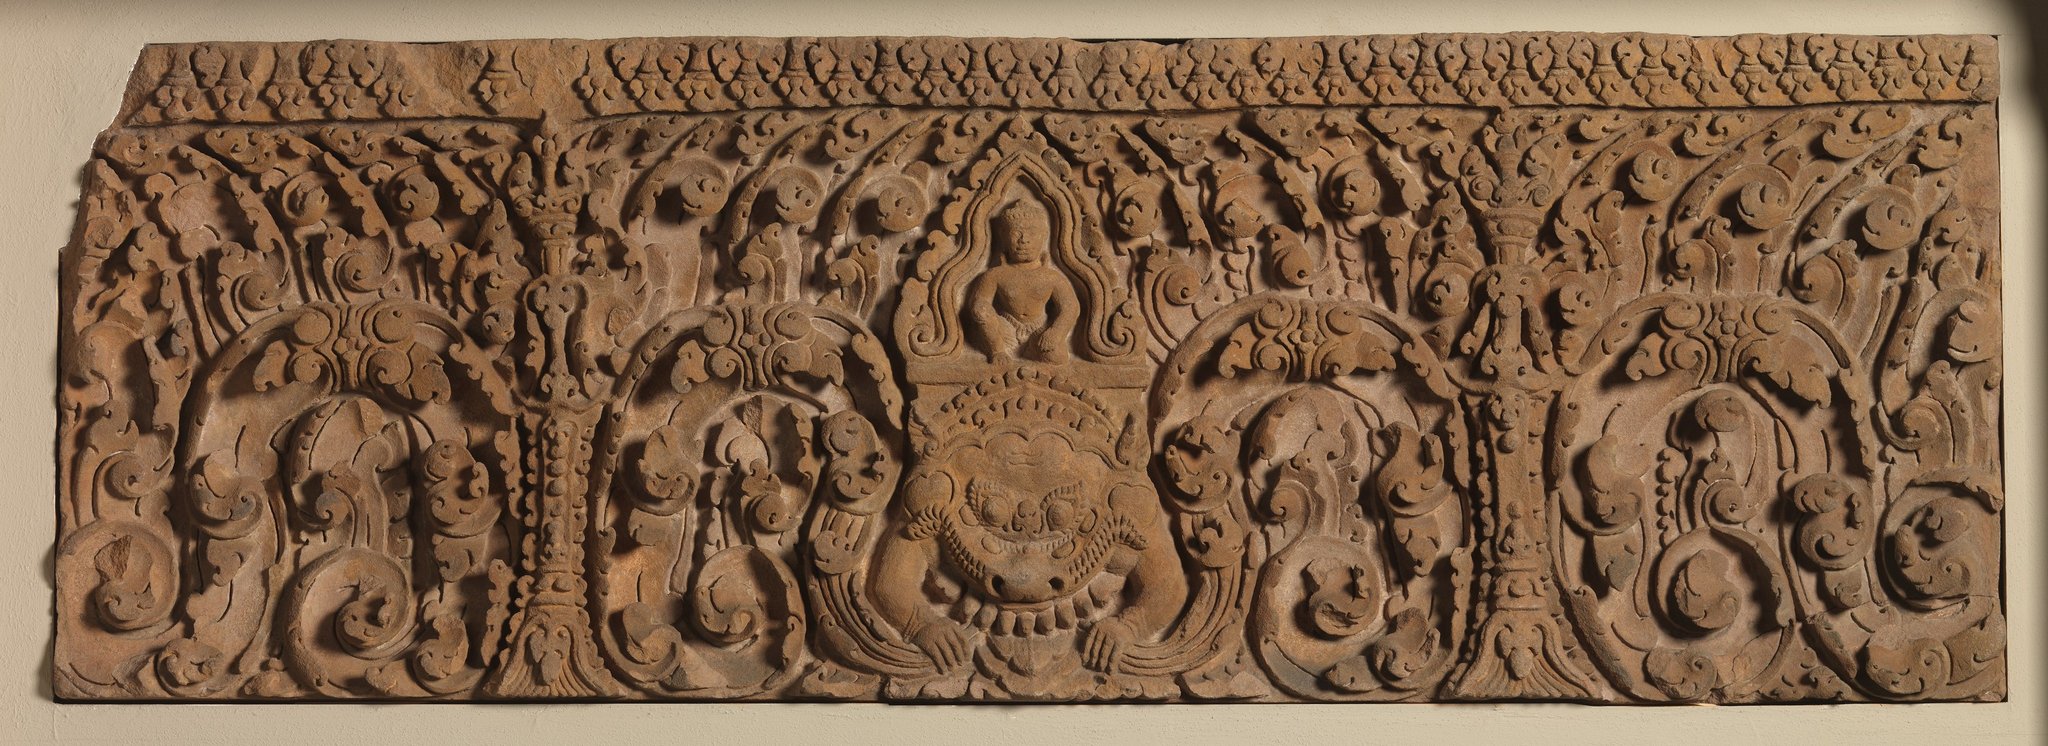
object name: lintel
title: Lintel with a Mask of Kala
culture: thai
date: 1001-1025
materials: stone